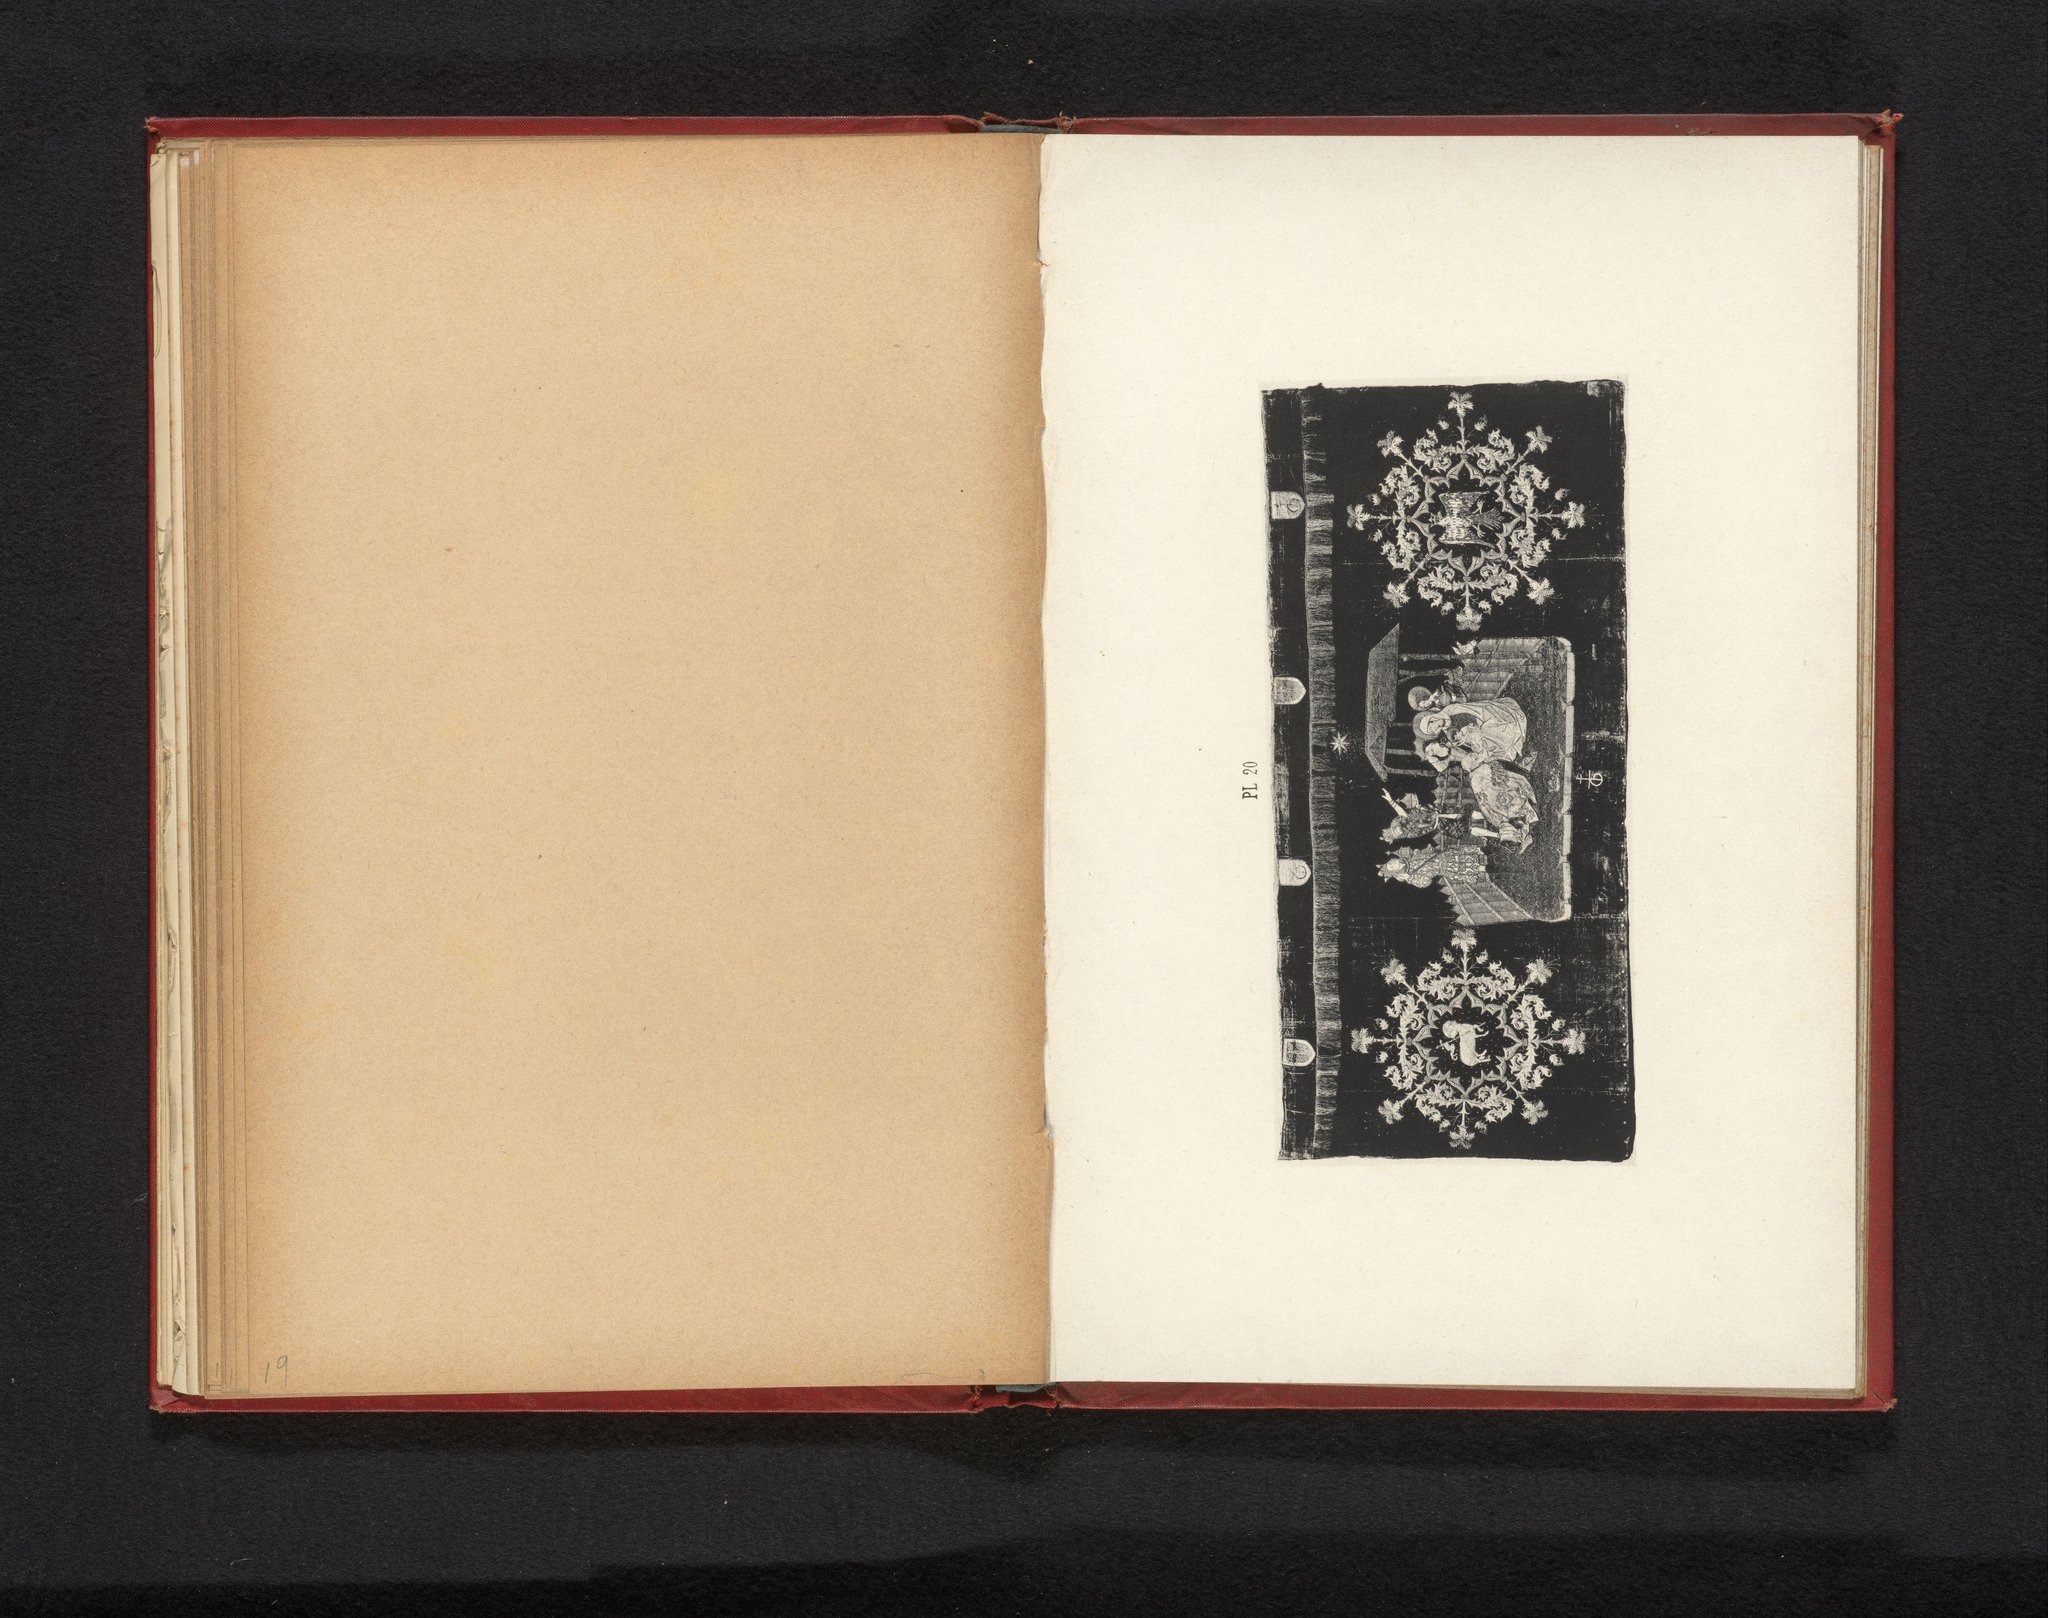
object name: page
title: Tapijt met een afbeelding van de Aanbidding der Koningen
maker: Anonymous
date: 1880-1881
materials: paper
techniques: photograph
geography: barcelona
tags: adoration of the kings: the wise men present their gifts to the christ-child (gold, frankincense and myrrh), carpet, rug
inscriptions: number: ‘Pl 20’